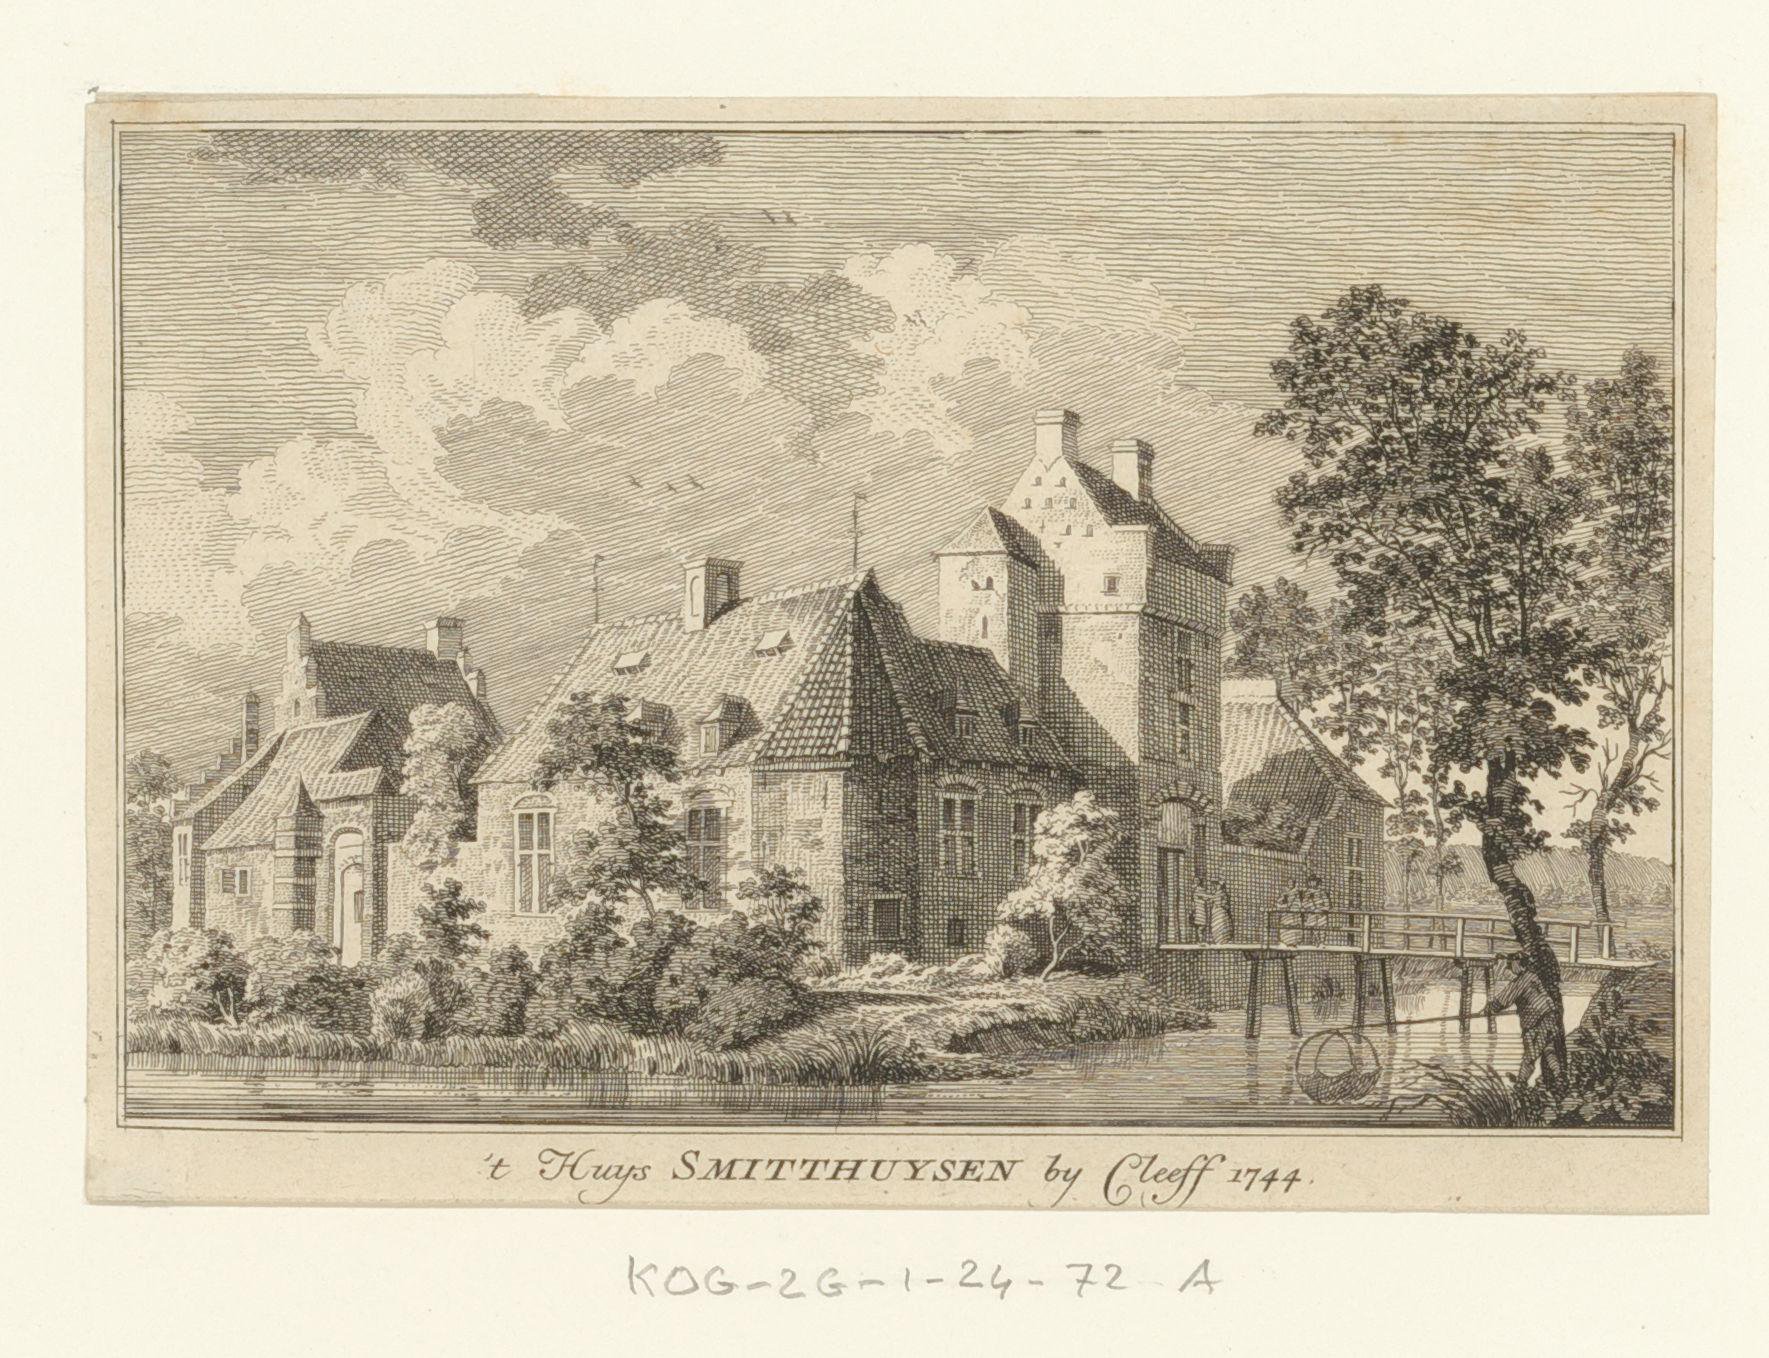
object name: print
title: Dorps- en stadsgezichten te Kleef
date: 1758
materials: paper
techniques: engraving, etching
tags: village, church (exterior), landscape with tower or castle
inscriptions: stamp, collector's mark: Lugt 1641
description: Onderwerpsrubrieken binnen de Atlas Zeden en Gewoonten: Zeden en Gewoonten in Engeren Zin, De Woning. Kastelen en buitenplaatsen. Het Kleefse.